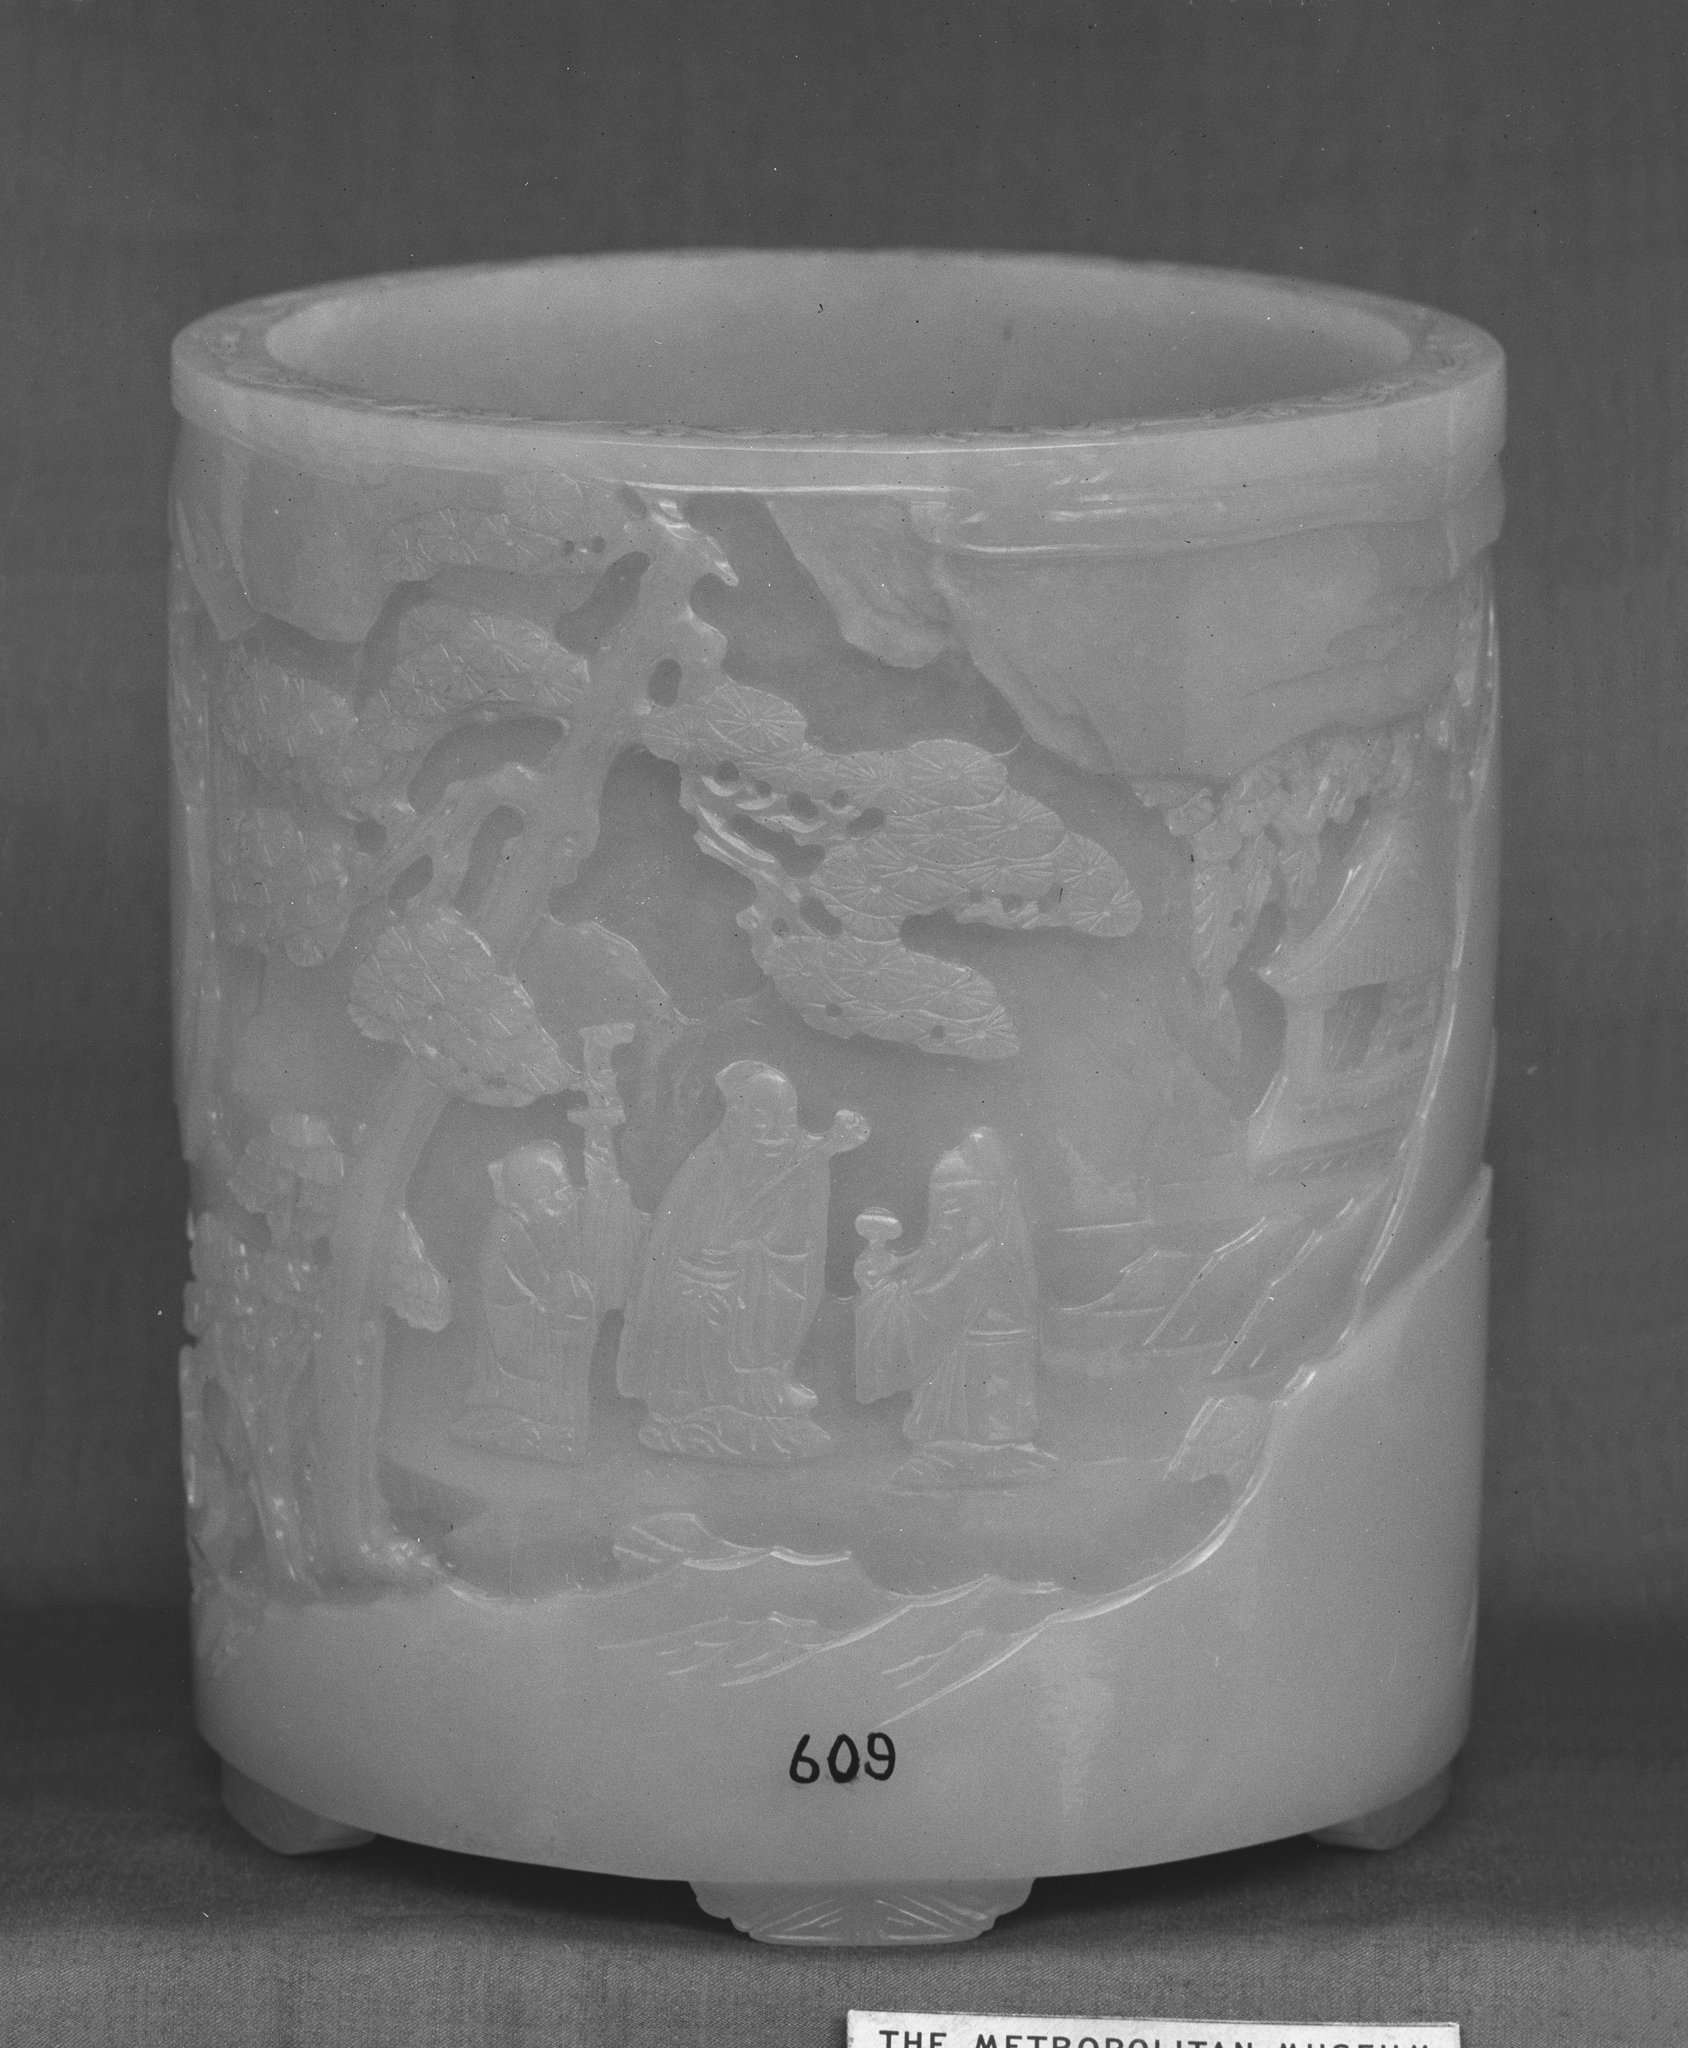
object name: brush holder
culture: chinese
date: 1736-1795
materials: jade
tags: human figures,trees